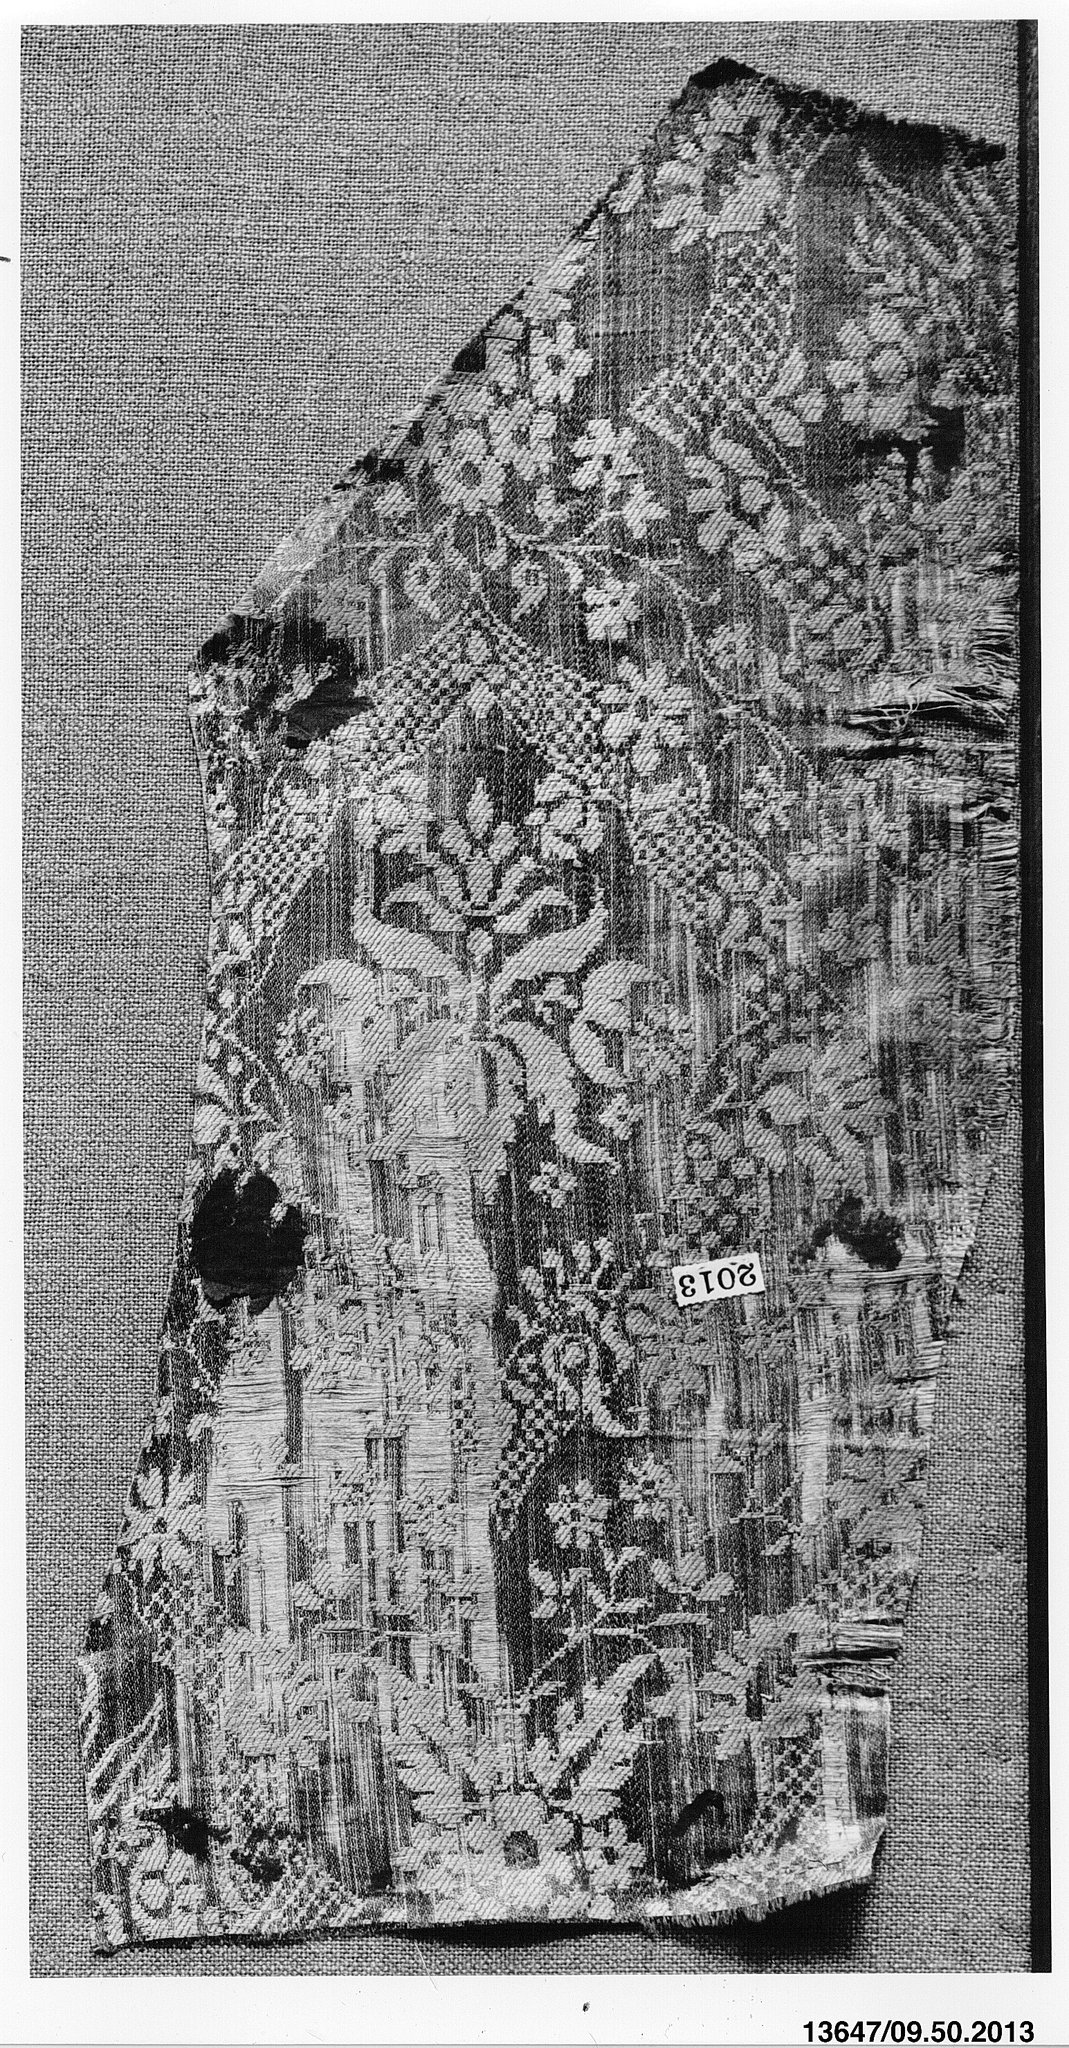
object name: fragment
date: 1801-1900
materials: cotton, silk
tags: flowers,leaves